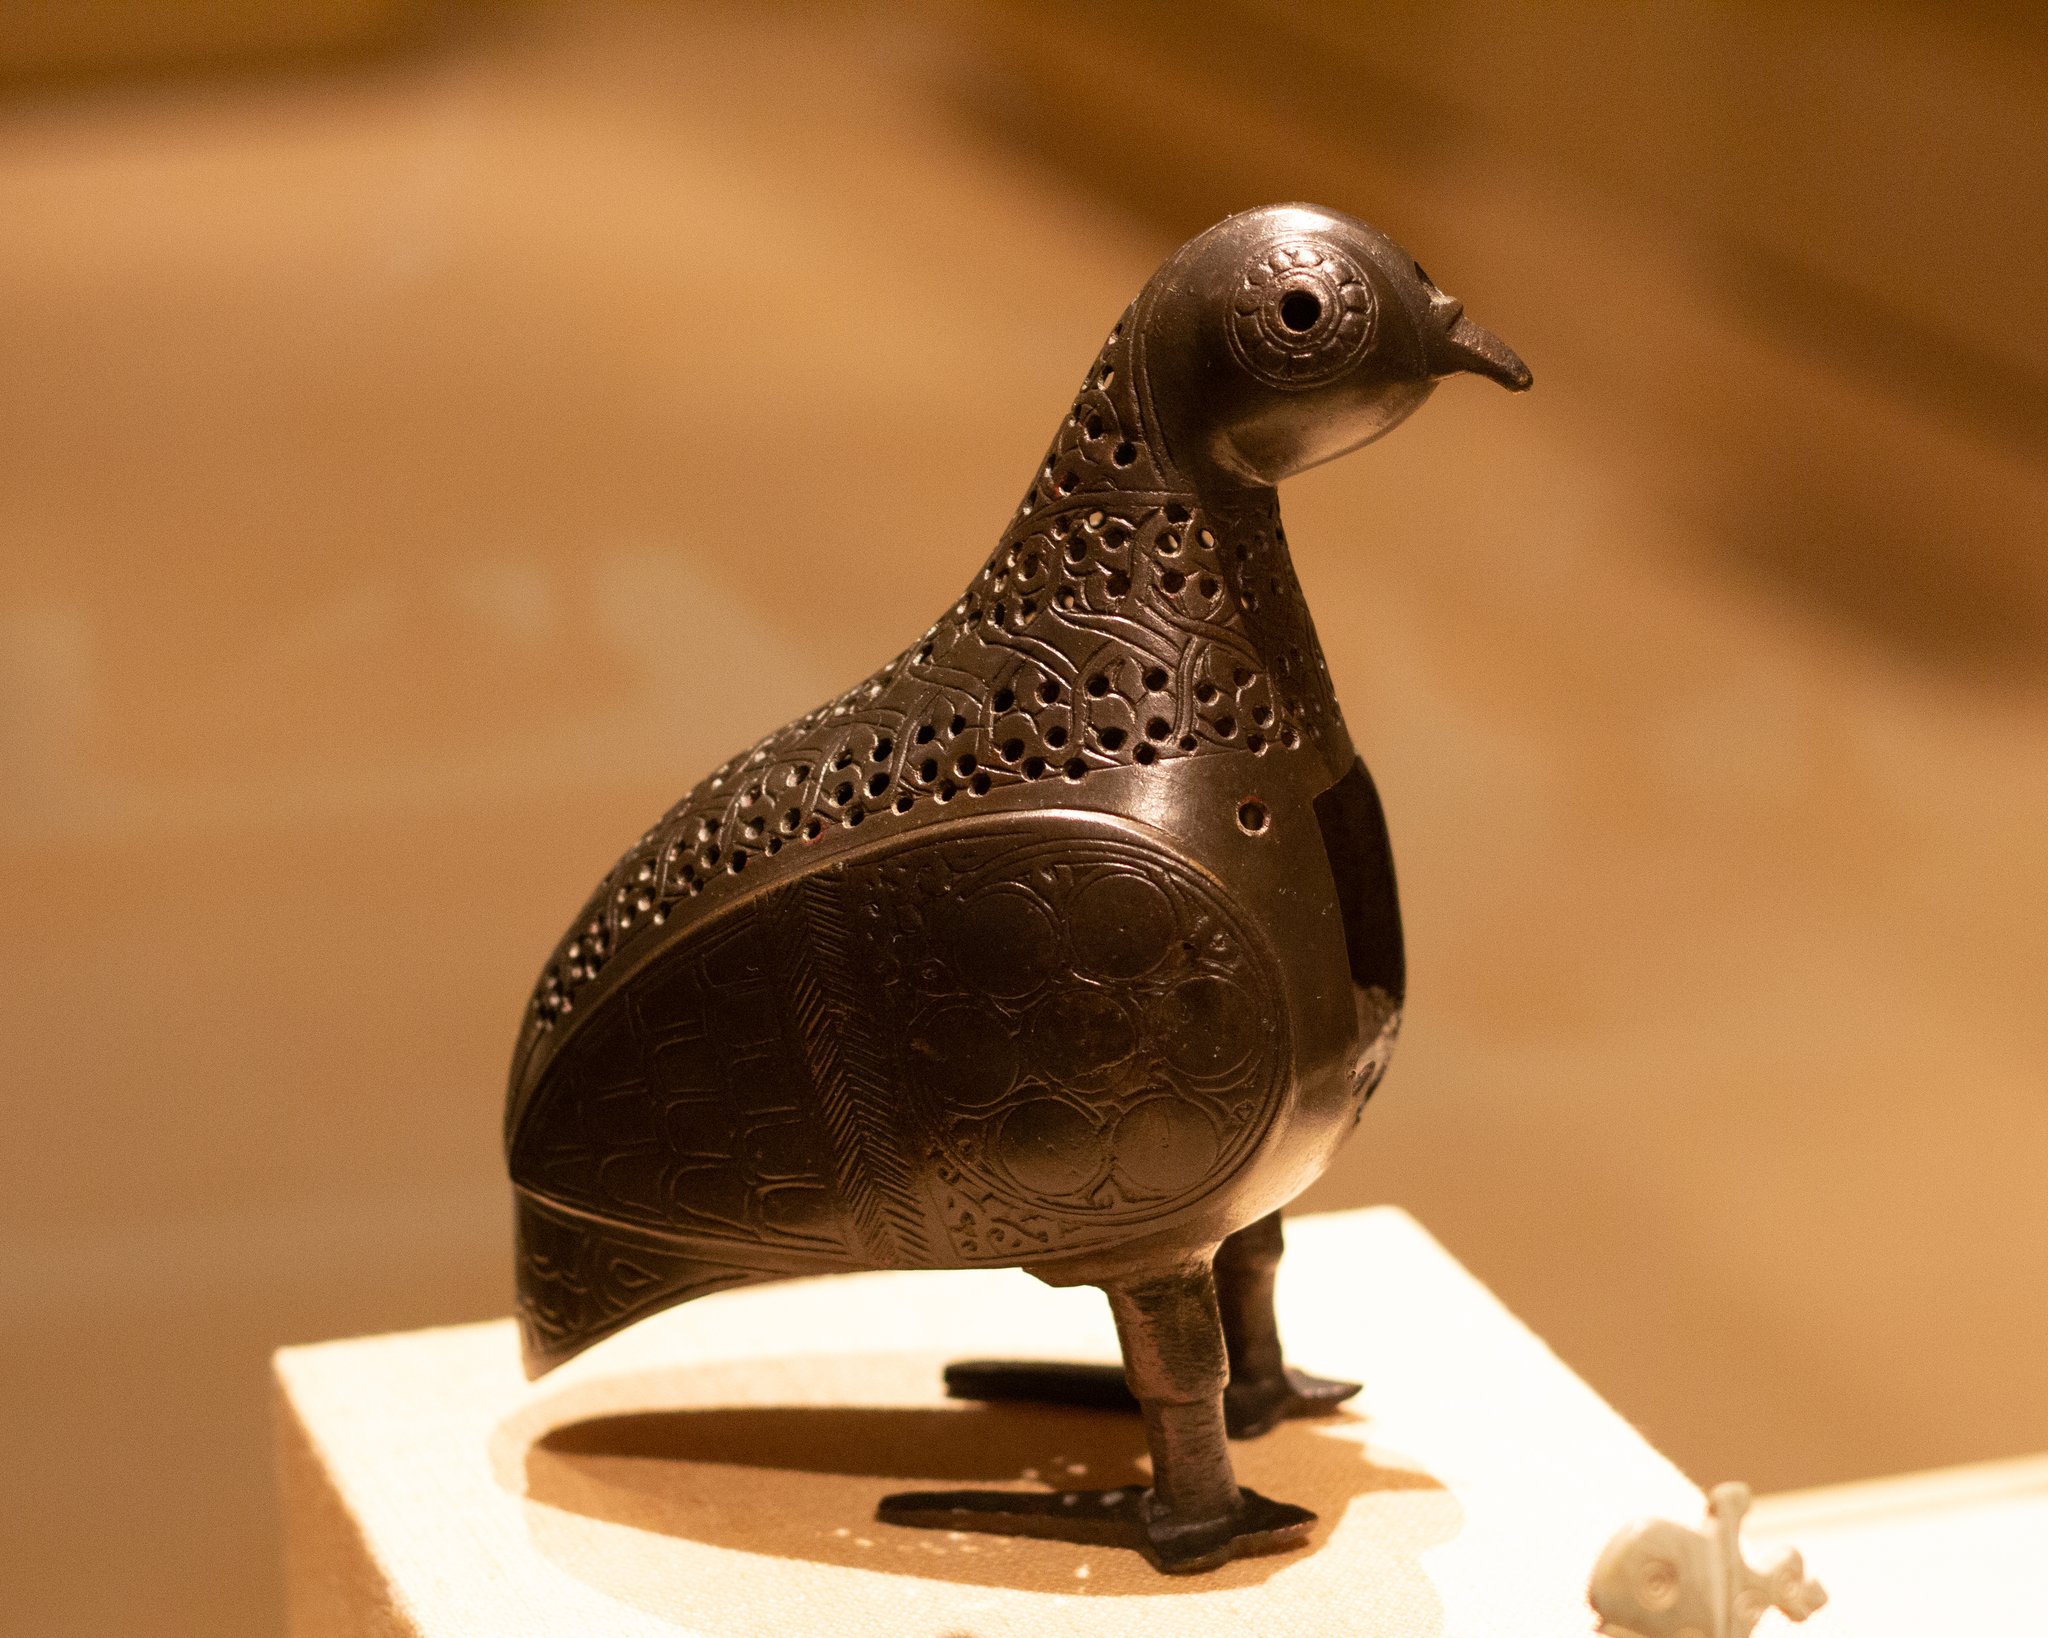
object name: incense burner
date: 1101-1200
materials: brass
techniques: casting, chasing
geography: iran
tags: birds